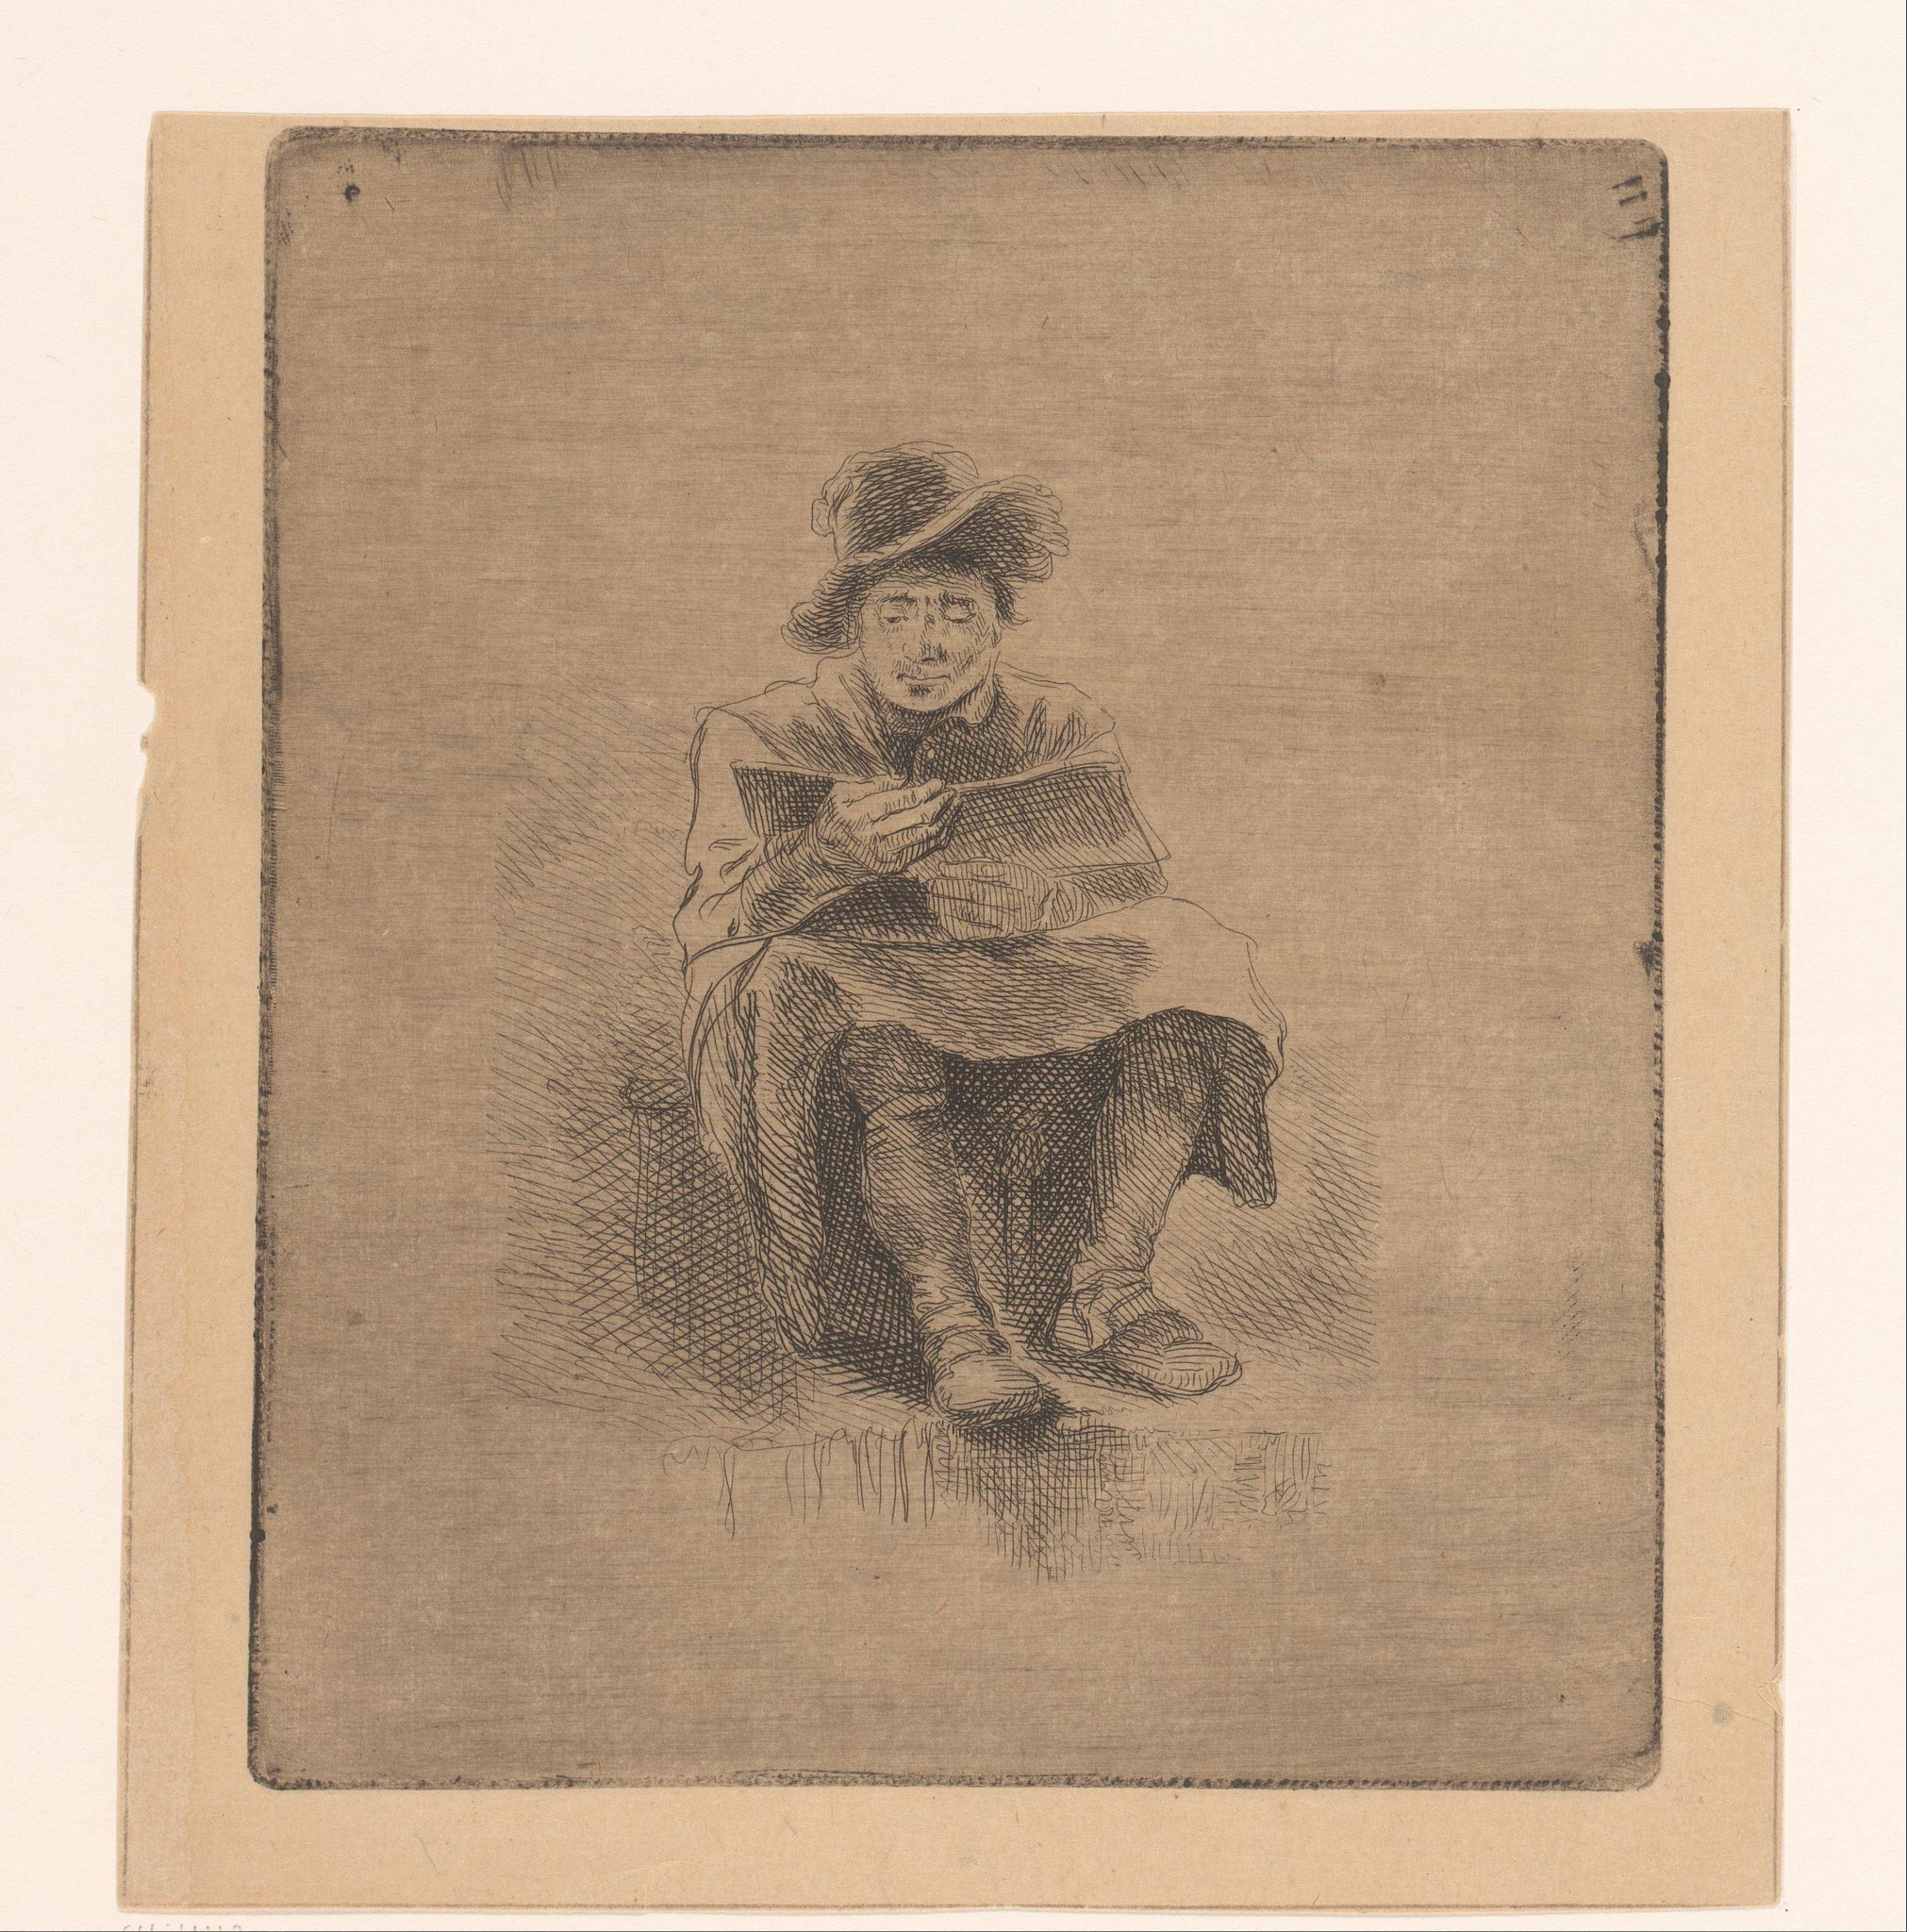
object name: print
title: Lezende man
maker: ignace-joseph de claussin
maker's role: print maker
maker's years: 1766-1844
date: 1805-1844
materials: paper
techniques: engraving, etching, intaglio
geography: france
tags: sitting figure, reading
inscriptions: collector's mark: Lugt 2228